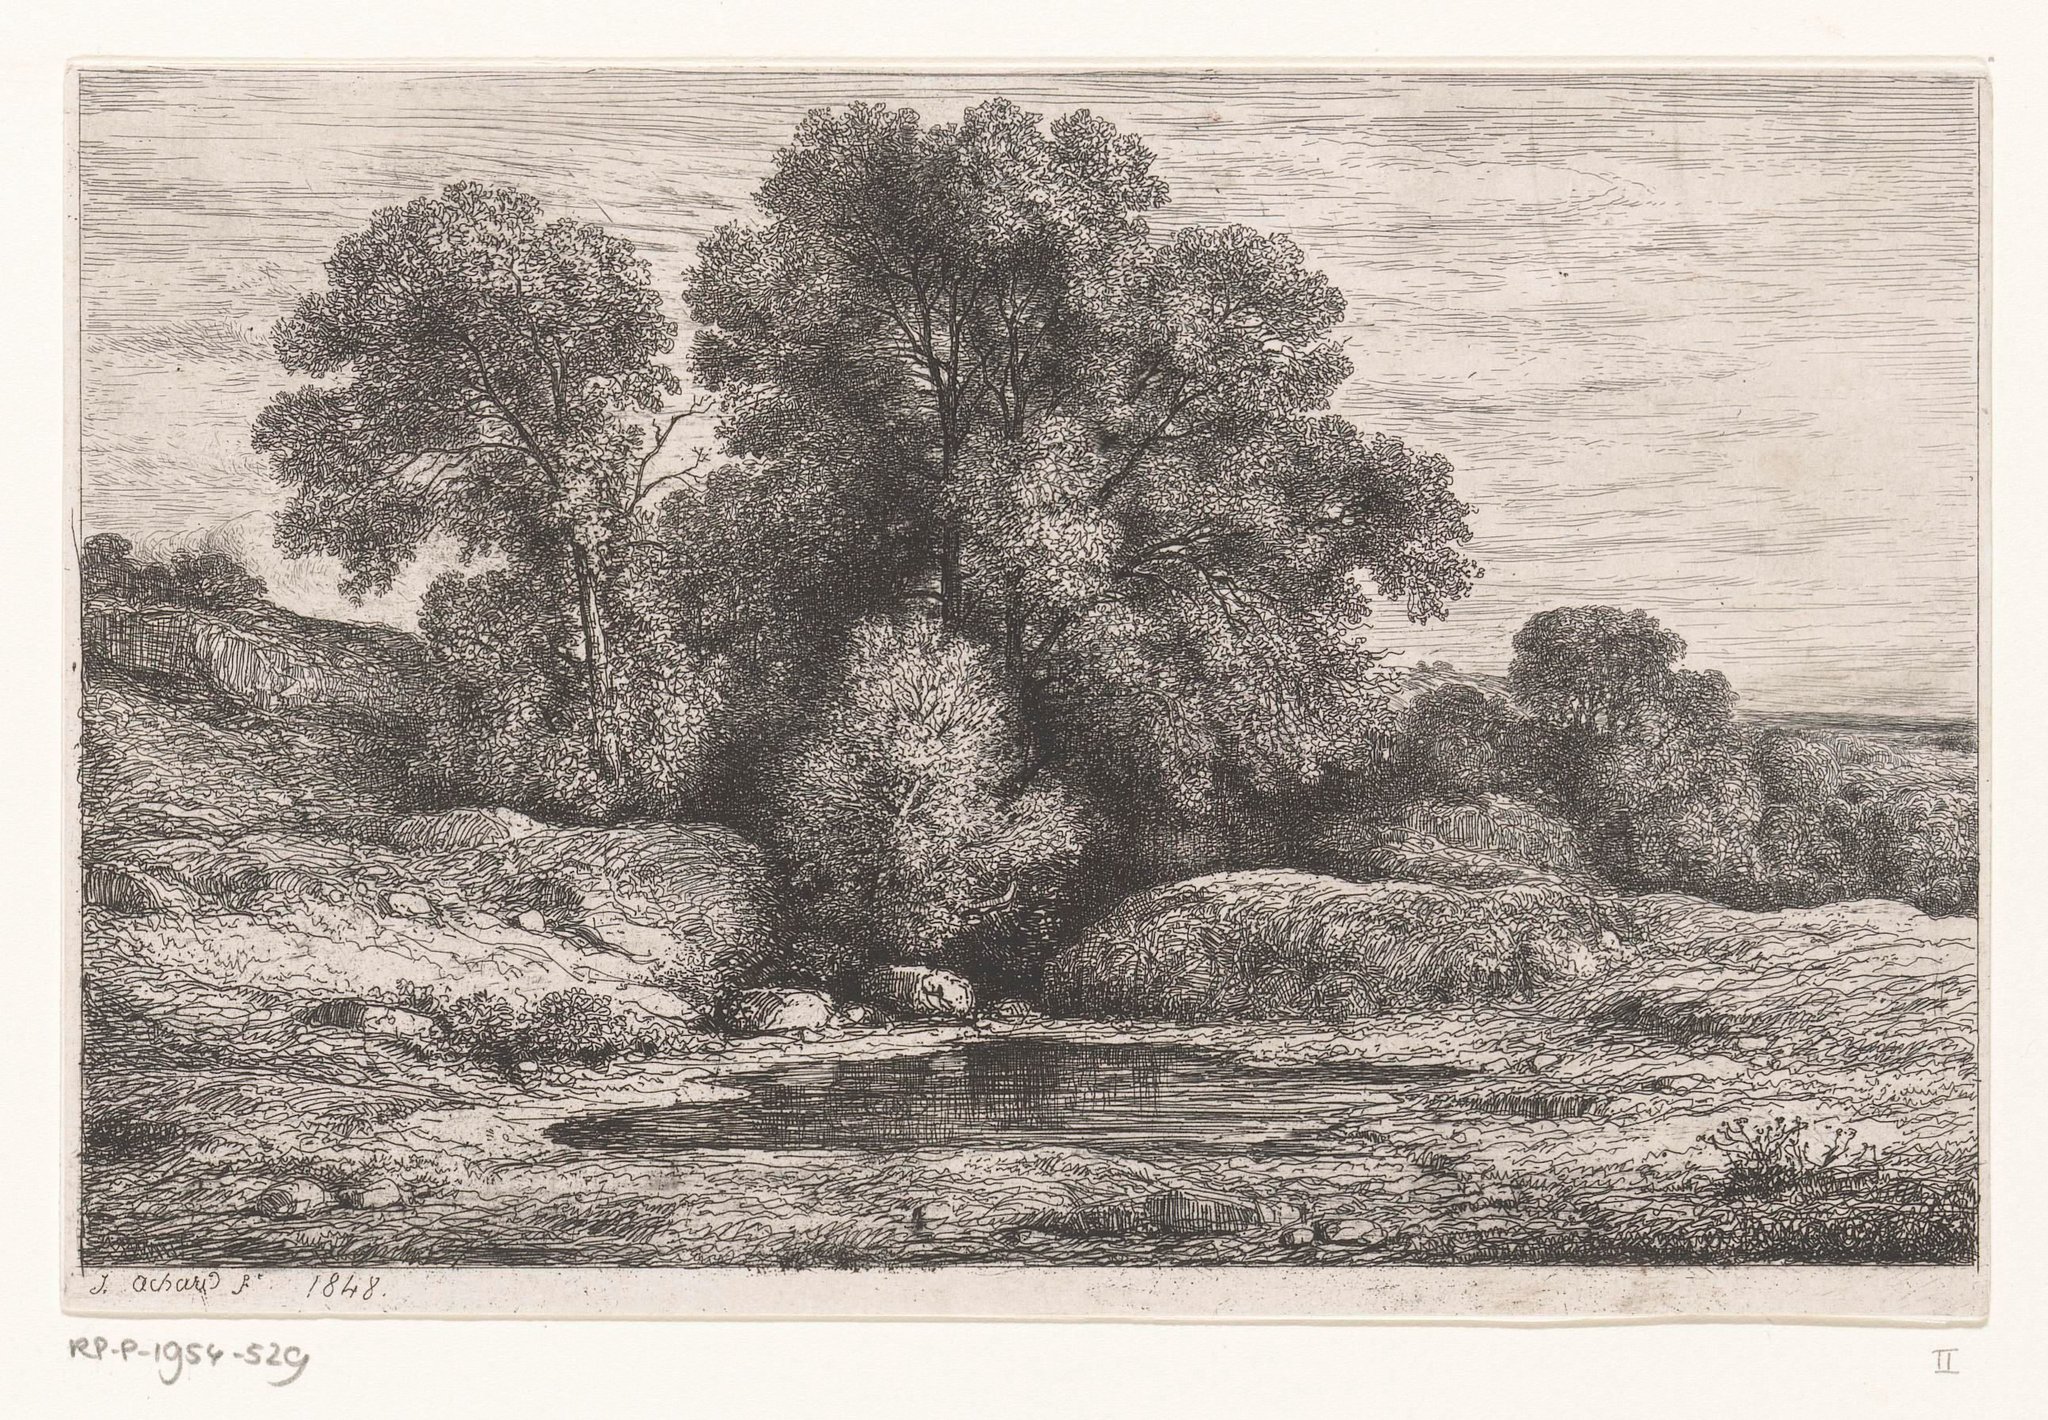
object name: print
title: Bomen bij een poel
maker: jean alexis achard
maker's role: print maker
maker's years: 1807-1884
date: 1848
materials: paper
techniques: etching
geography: france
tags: trees, landscapes, pond, pool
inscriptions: collector's mark: Lugt 2228